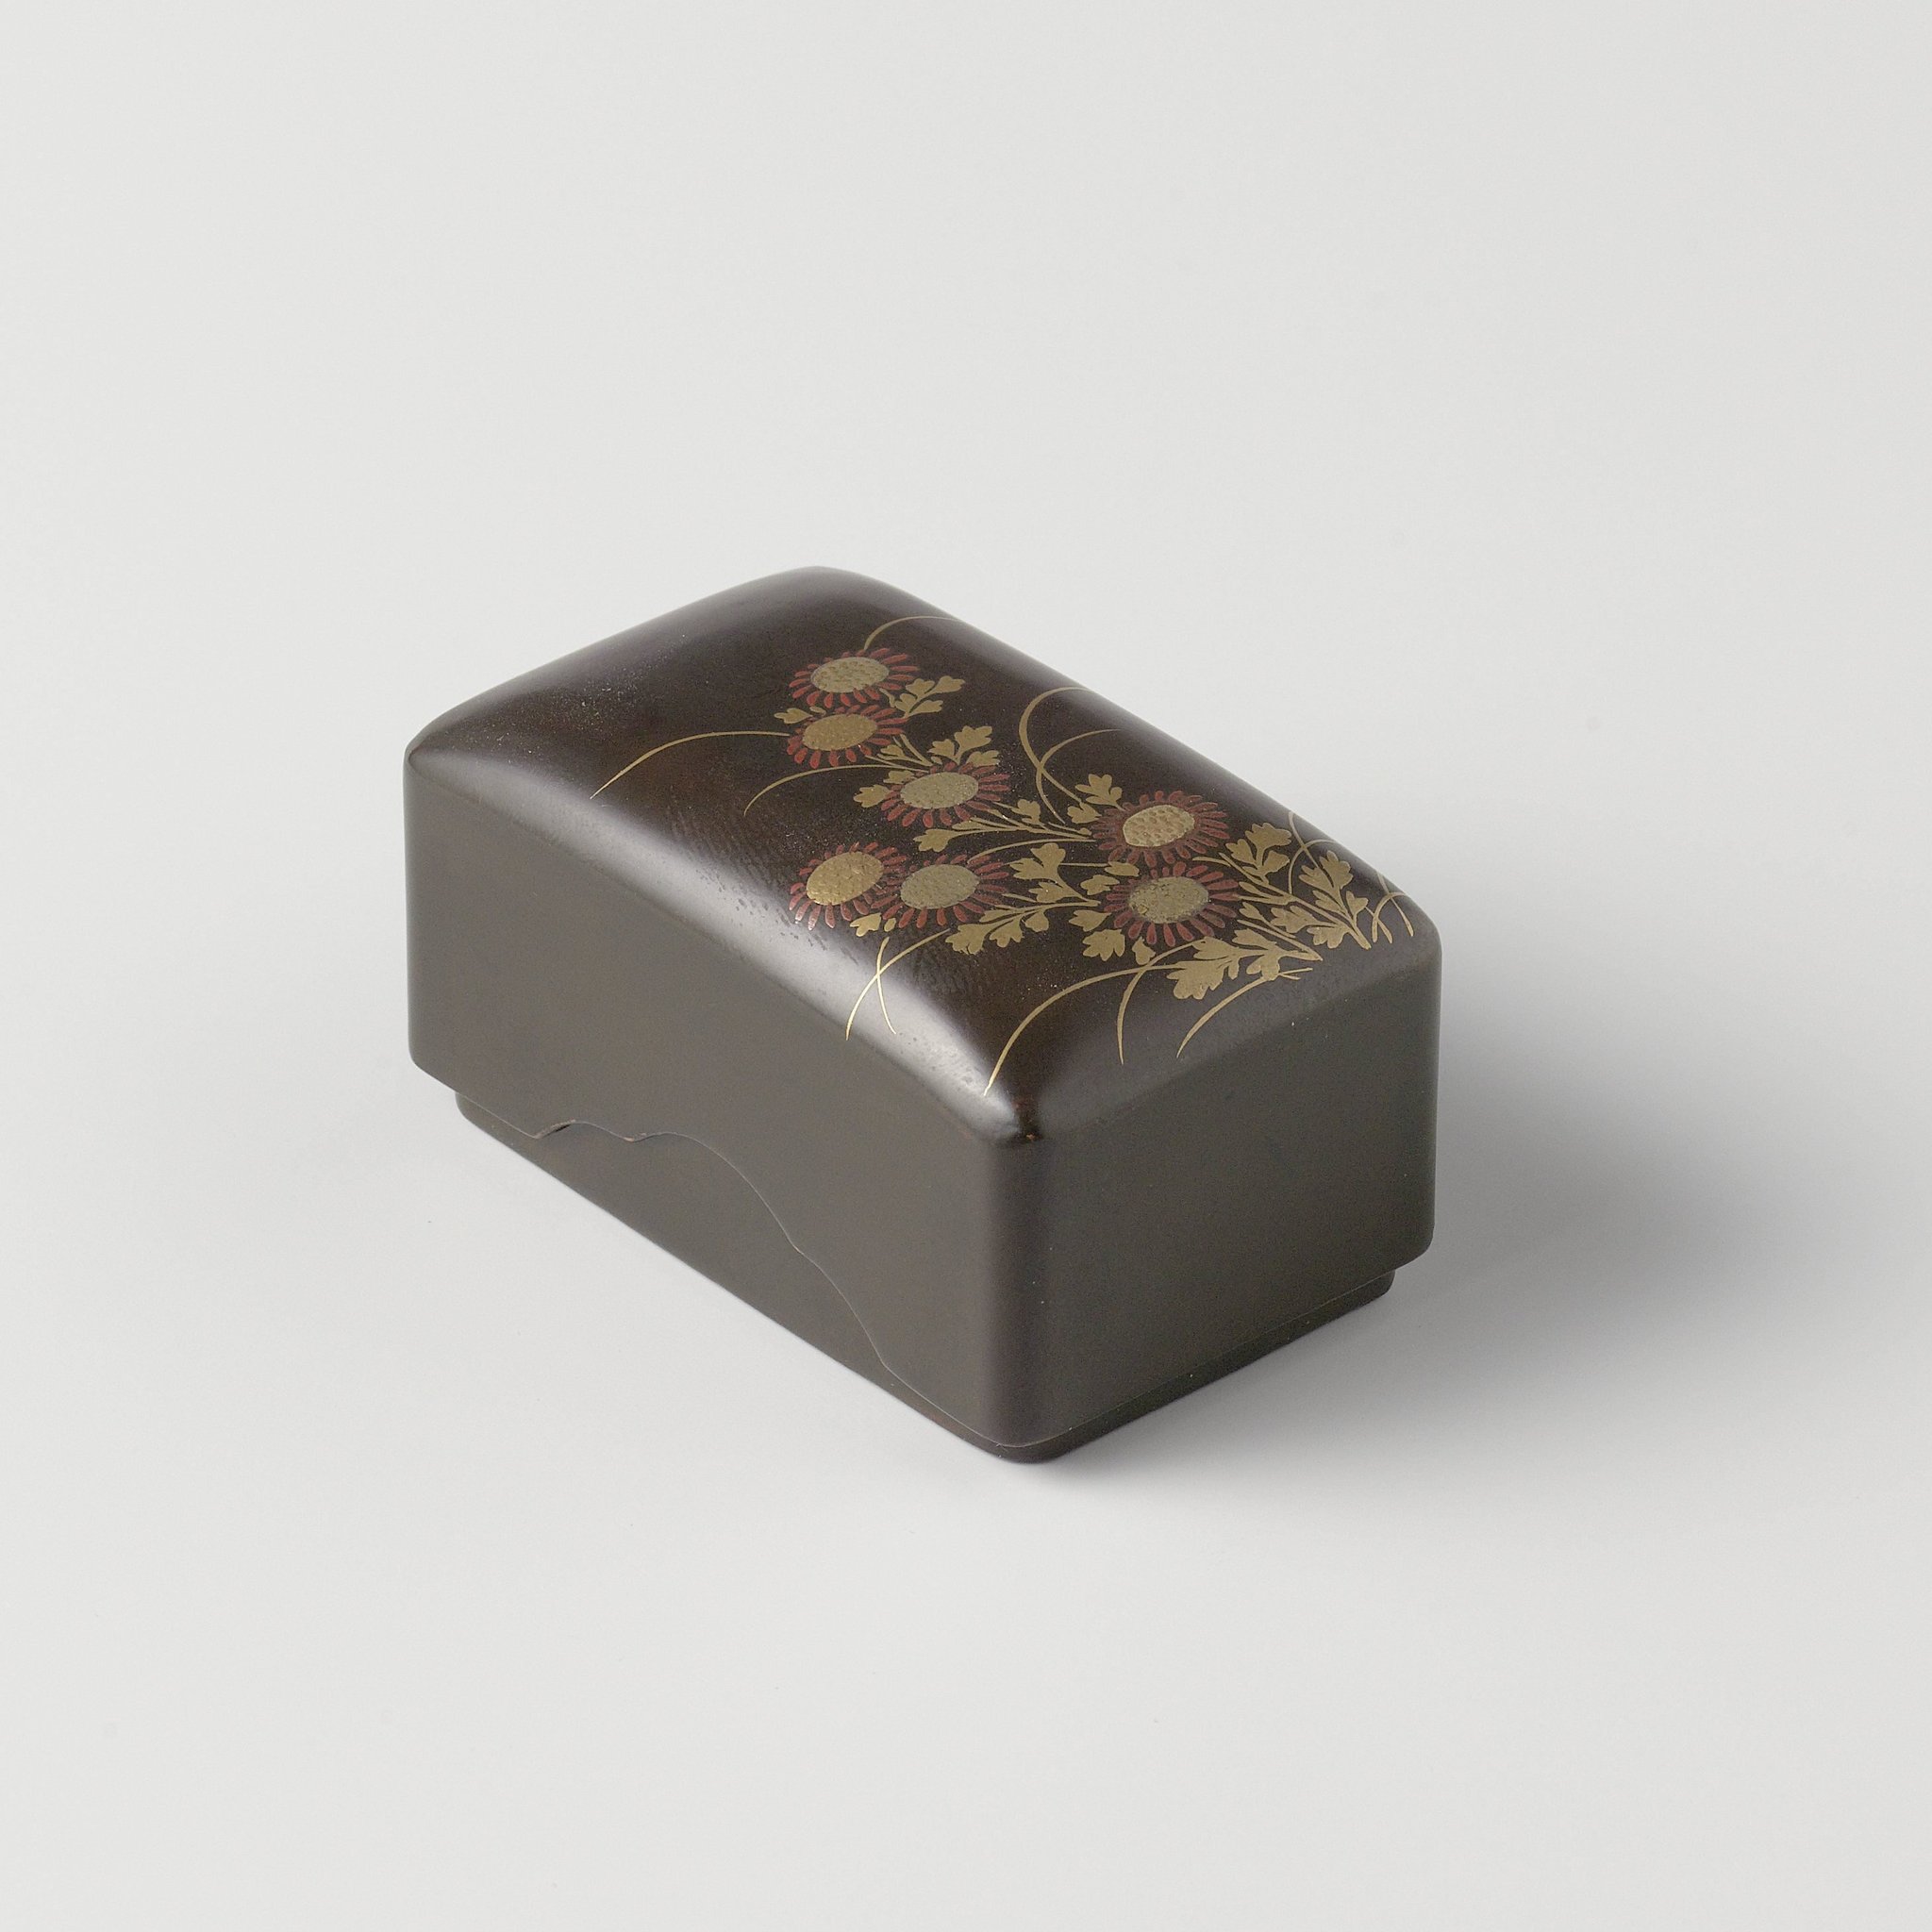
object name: box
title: Doos met deksel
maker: Anonymous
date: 1700-1850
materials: lacquer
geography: japan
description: Langwerpig doosje met overhangende deksel. Lakwerk, versierd in makie met op de bovenkant van de deksel bloeiende chrysanten.